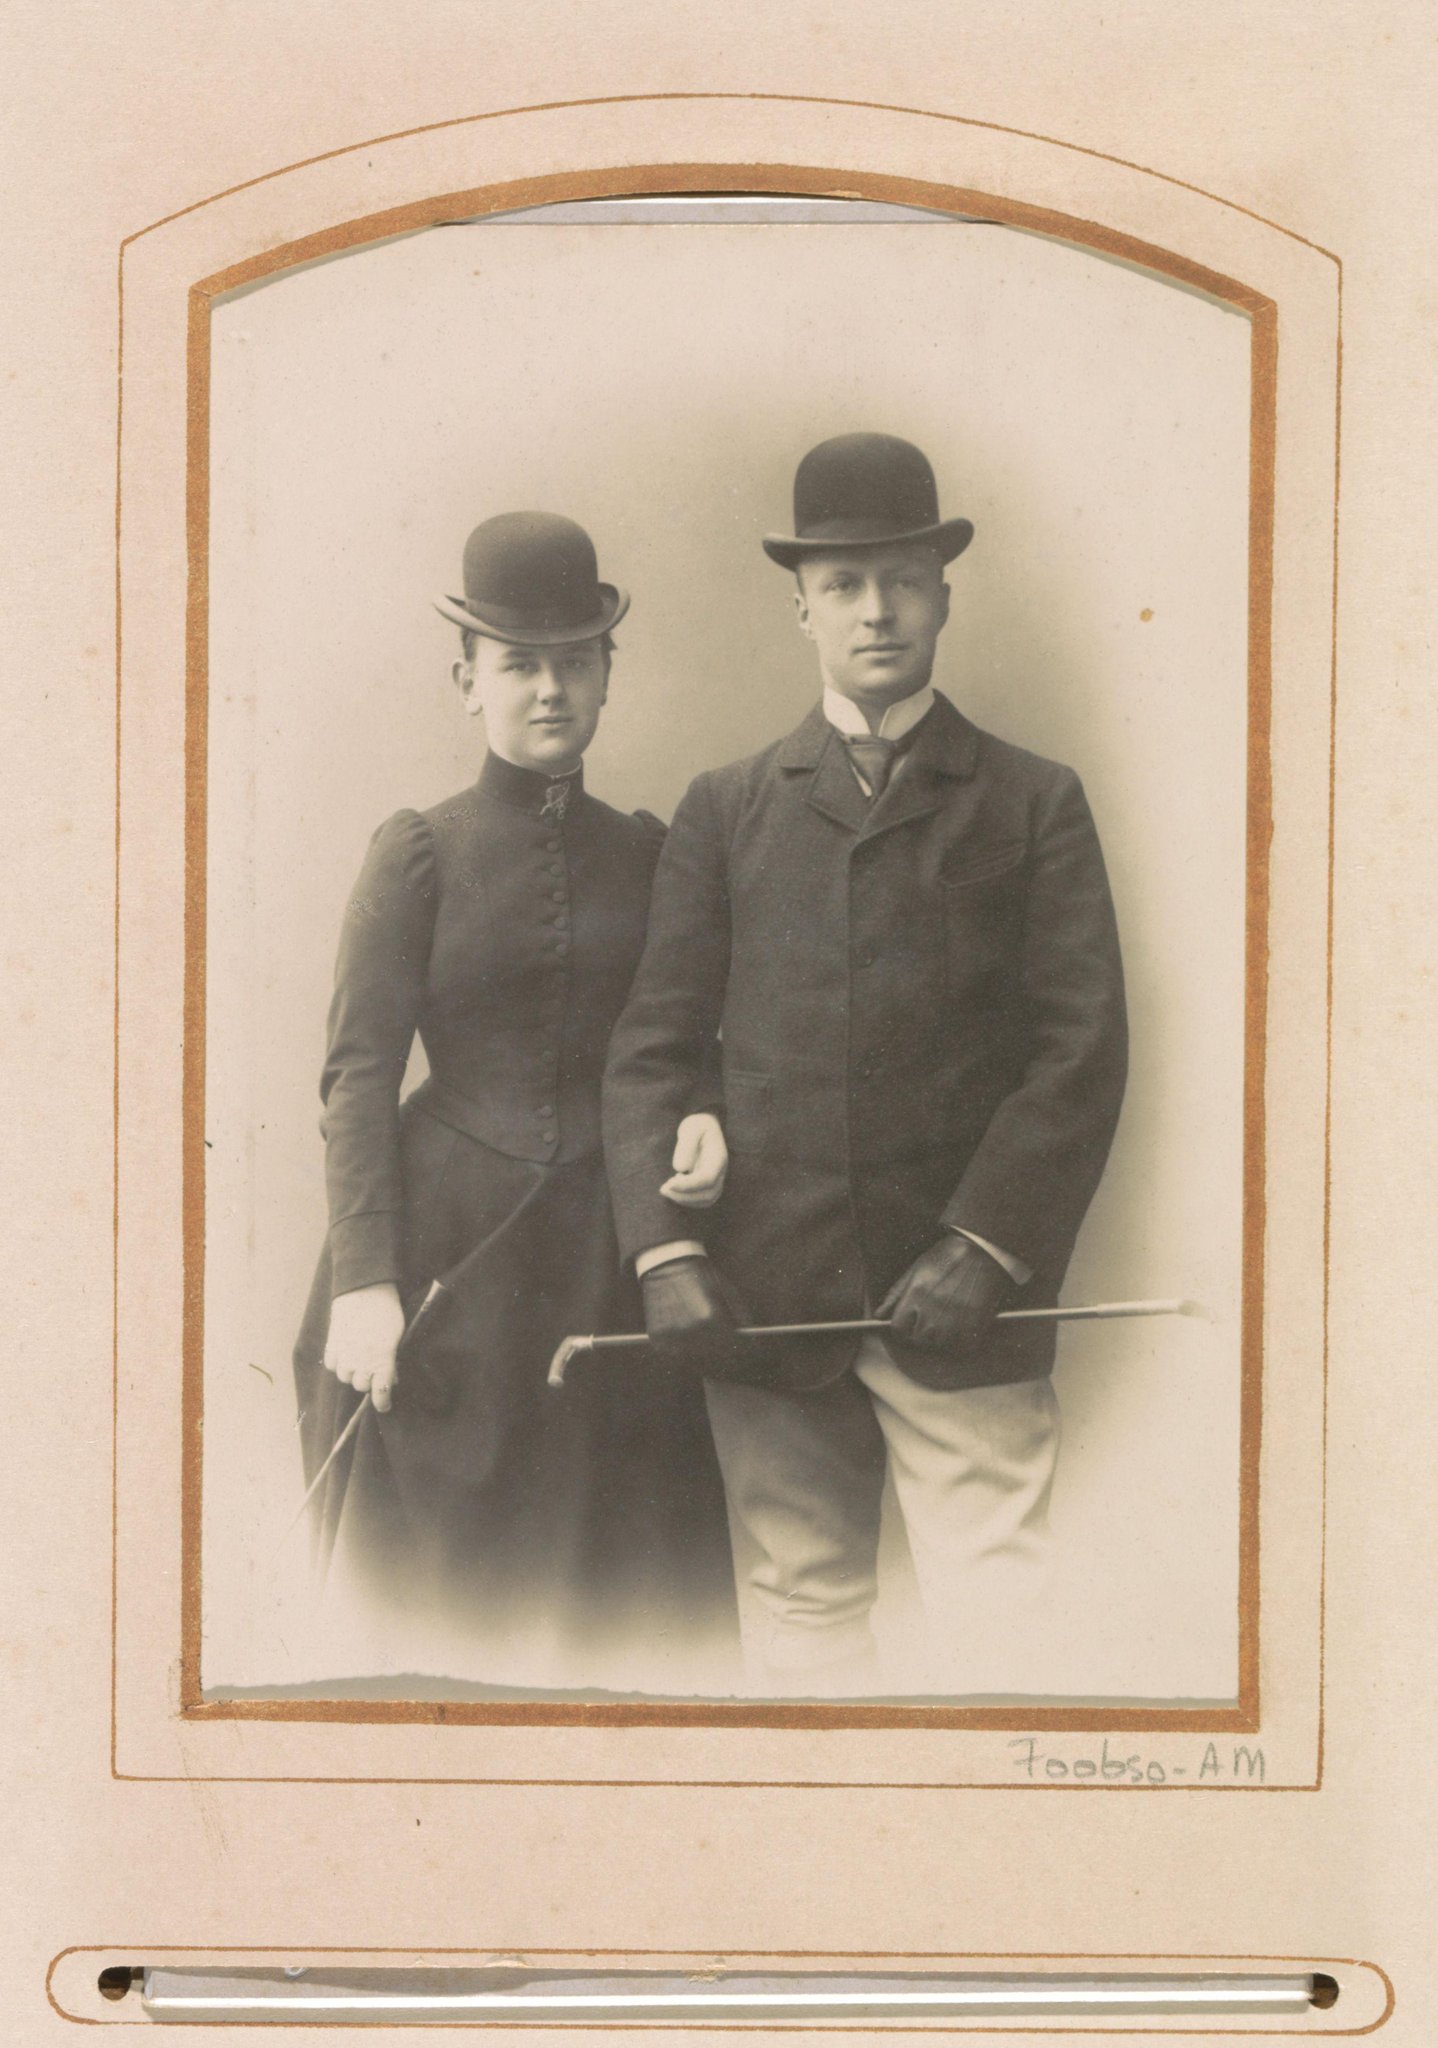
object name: album leaf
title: Portret van koningin Wilhelmina en prins Hendrik in rijkostuum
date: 1900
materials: paper, cardboard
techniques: gelatin silver print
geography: amsterdam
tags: print maker, wilhelmina of the netherlands, the hague, hendrik (prins der nederlanden (1876-1934)), head-gear: bowler hat, prince, historical persons, queen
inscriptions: inscription: ‘Wegner & Mottu/ Rokin 138/ Amsterdam.’